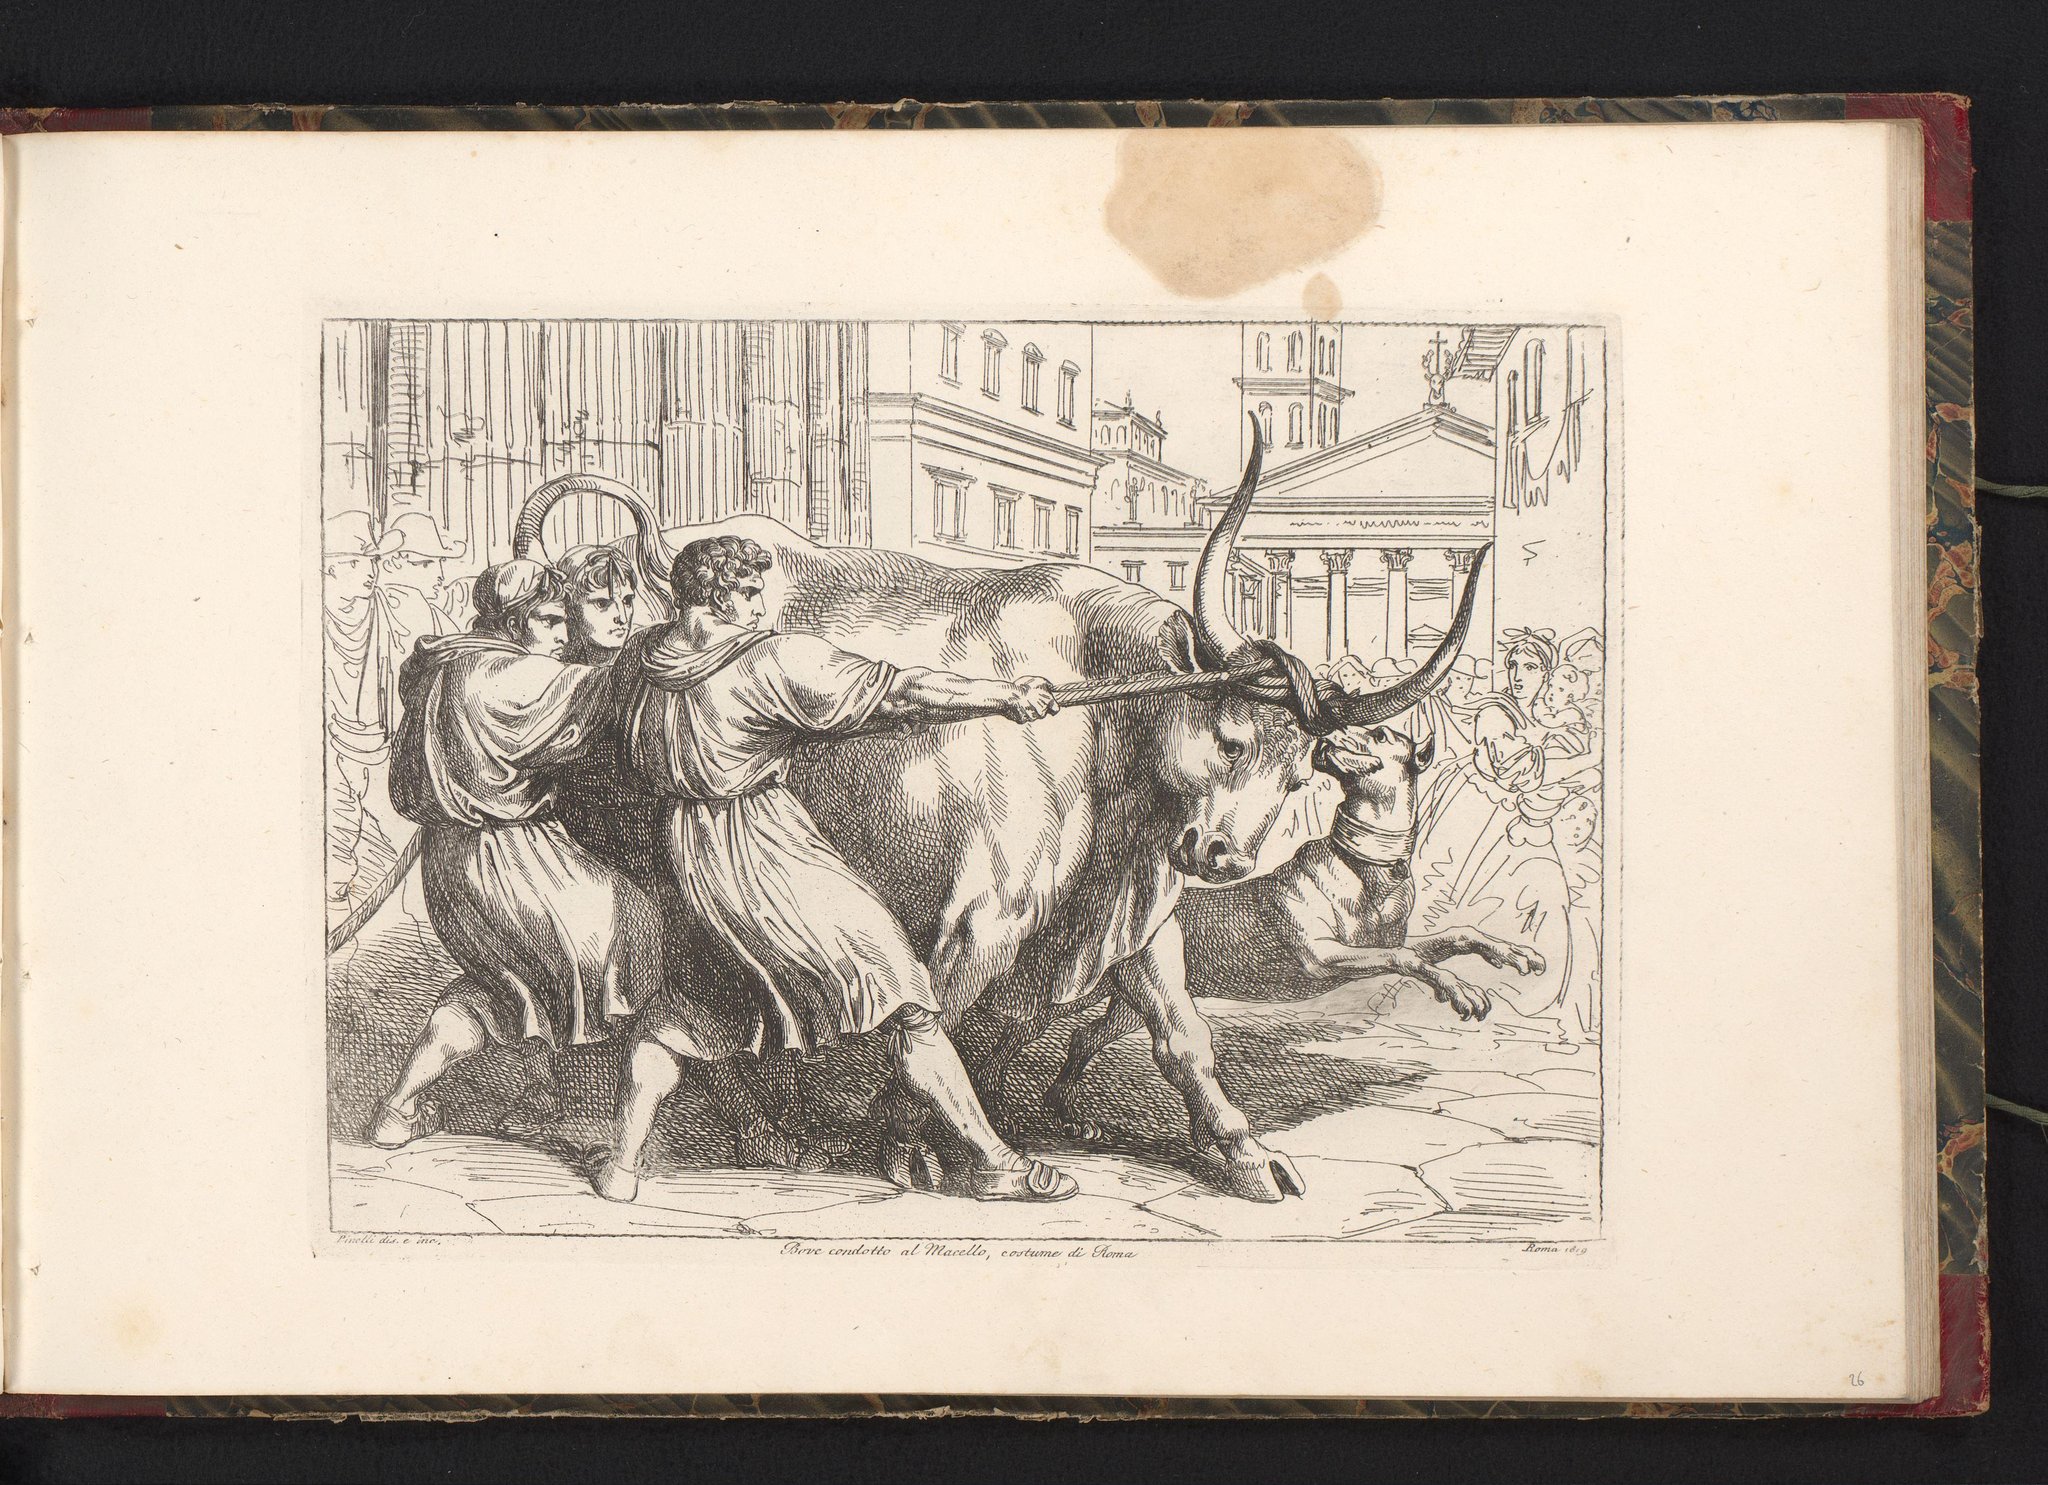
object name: album leaf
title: Bove condotto al Macello, costume di Roma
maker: bartolomeo pinelli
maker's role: draughtsman, print maker, sculptor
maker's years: 1781-1835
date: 1819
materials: paper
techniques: etching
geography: rome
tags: bull, city-view in general; 'veduta', folk costume, regional costume, man struggling with animals, rome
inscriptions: date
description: Op een stadsplein wordt een stier door drie Romeinse mannen meegetrokken aan een touw dat om zijn hoorns is gebonden. Op de achtergrond een kerk en verscheidene toeschouwers. De prent maakt deel uit van een album.